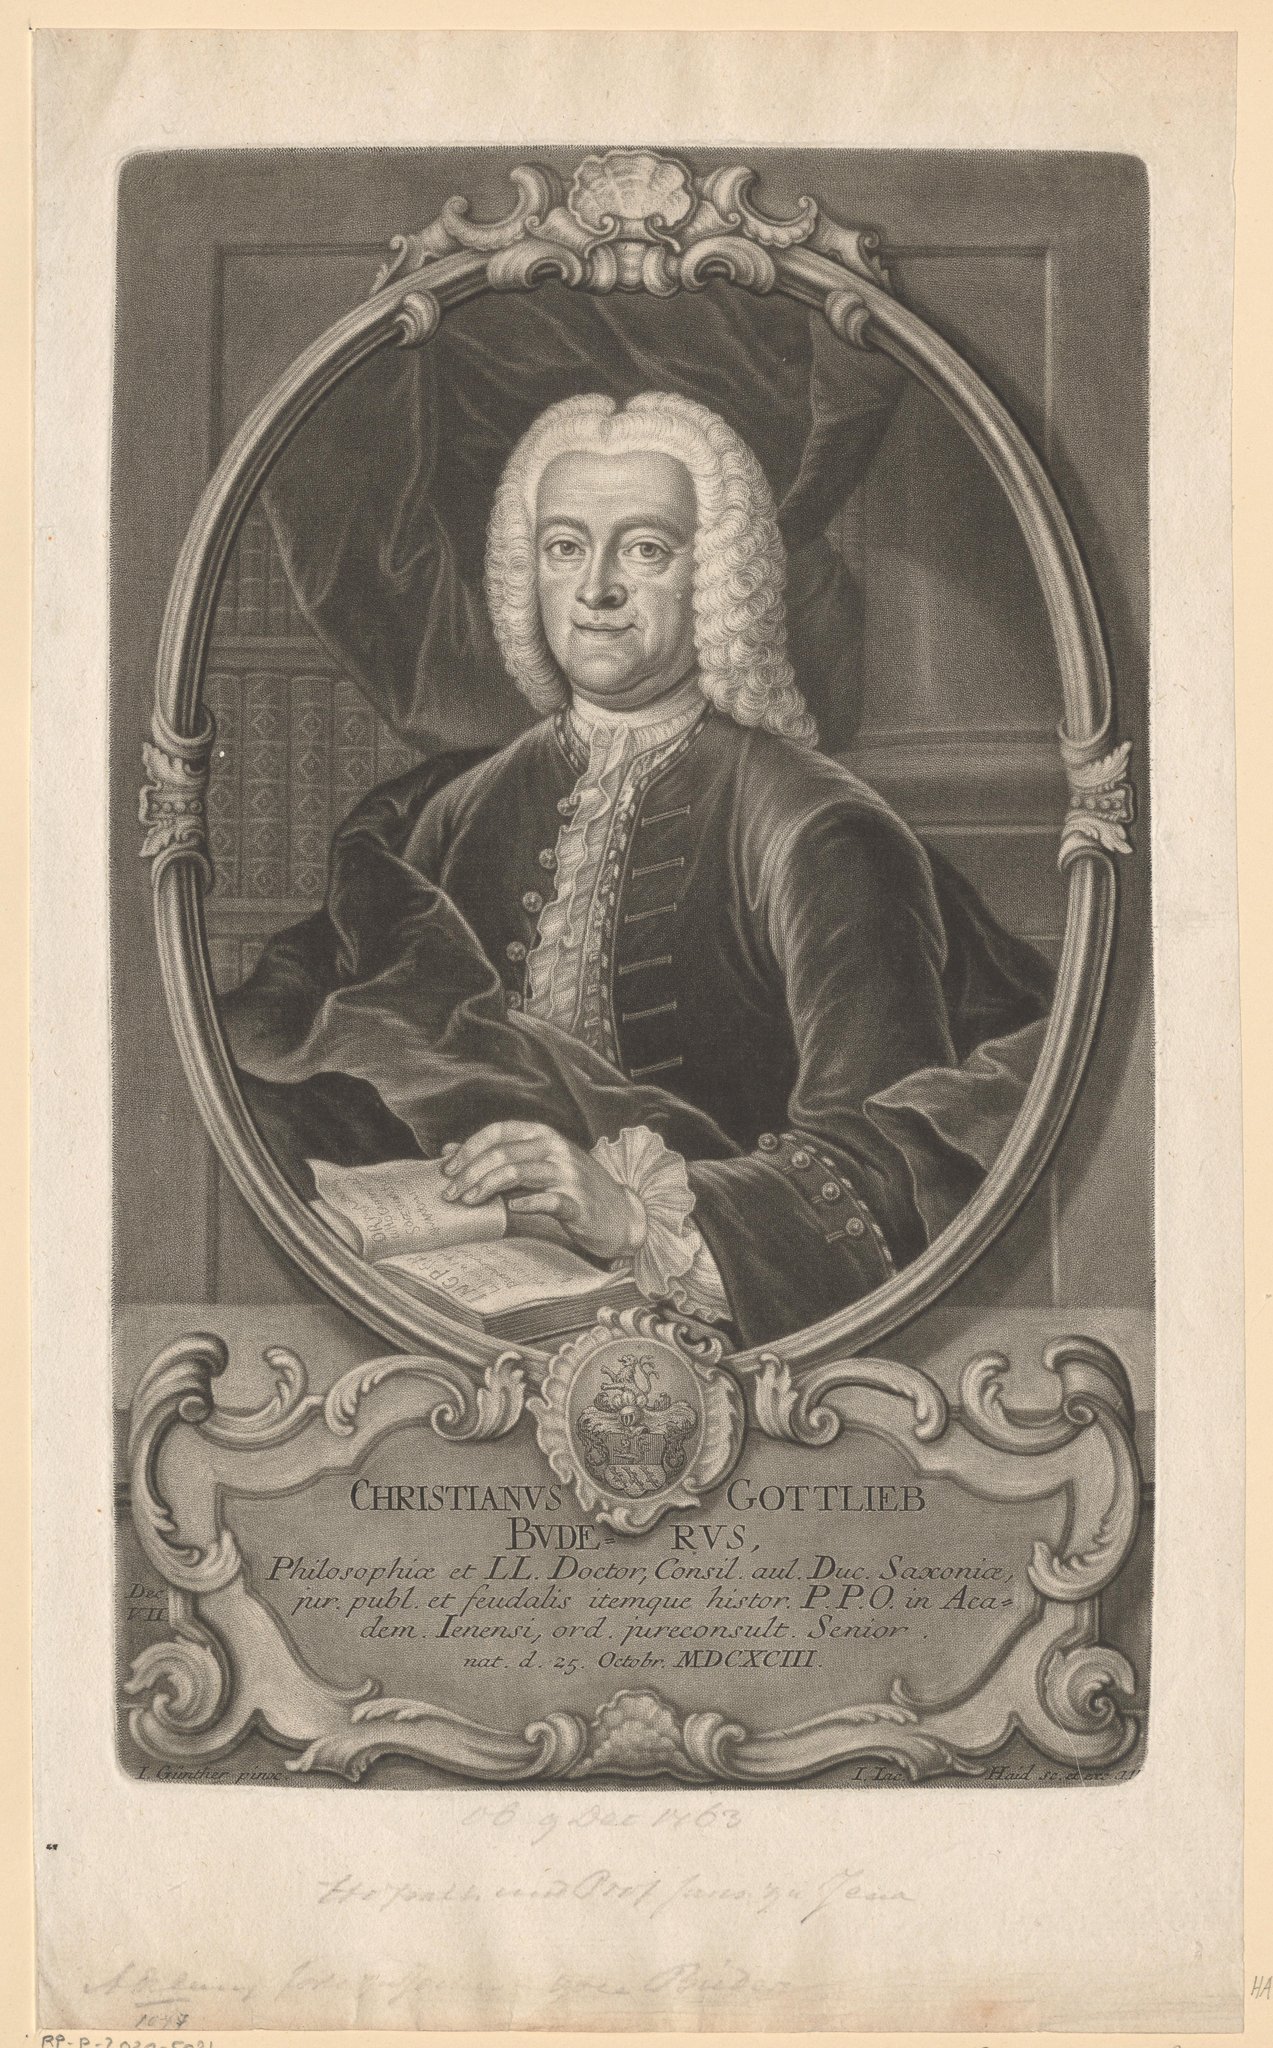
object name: print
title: Portret van Christian Gottlieb Buder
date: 1737-1767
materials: paper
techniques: engraving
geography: augsburg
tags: bookshelves, scholar, philosopher, historical persons, armorial bearing, heraldry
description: Prent waarschijnlijk uit: Brucker, Jacob. Bilder-sal heutiges Tages lebender und durch Gelahrtheit berühmter Schrifft-steller (...). Augsburg: Johann Jacob Haid, 1748, dl. 7.